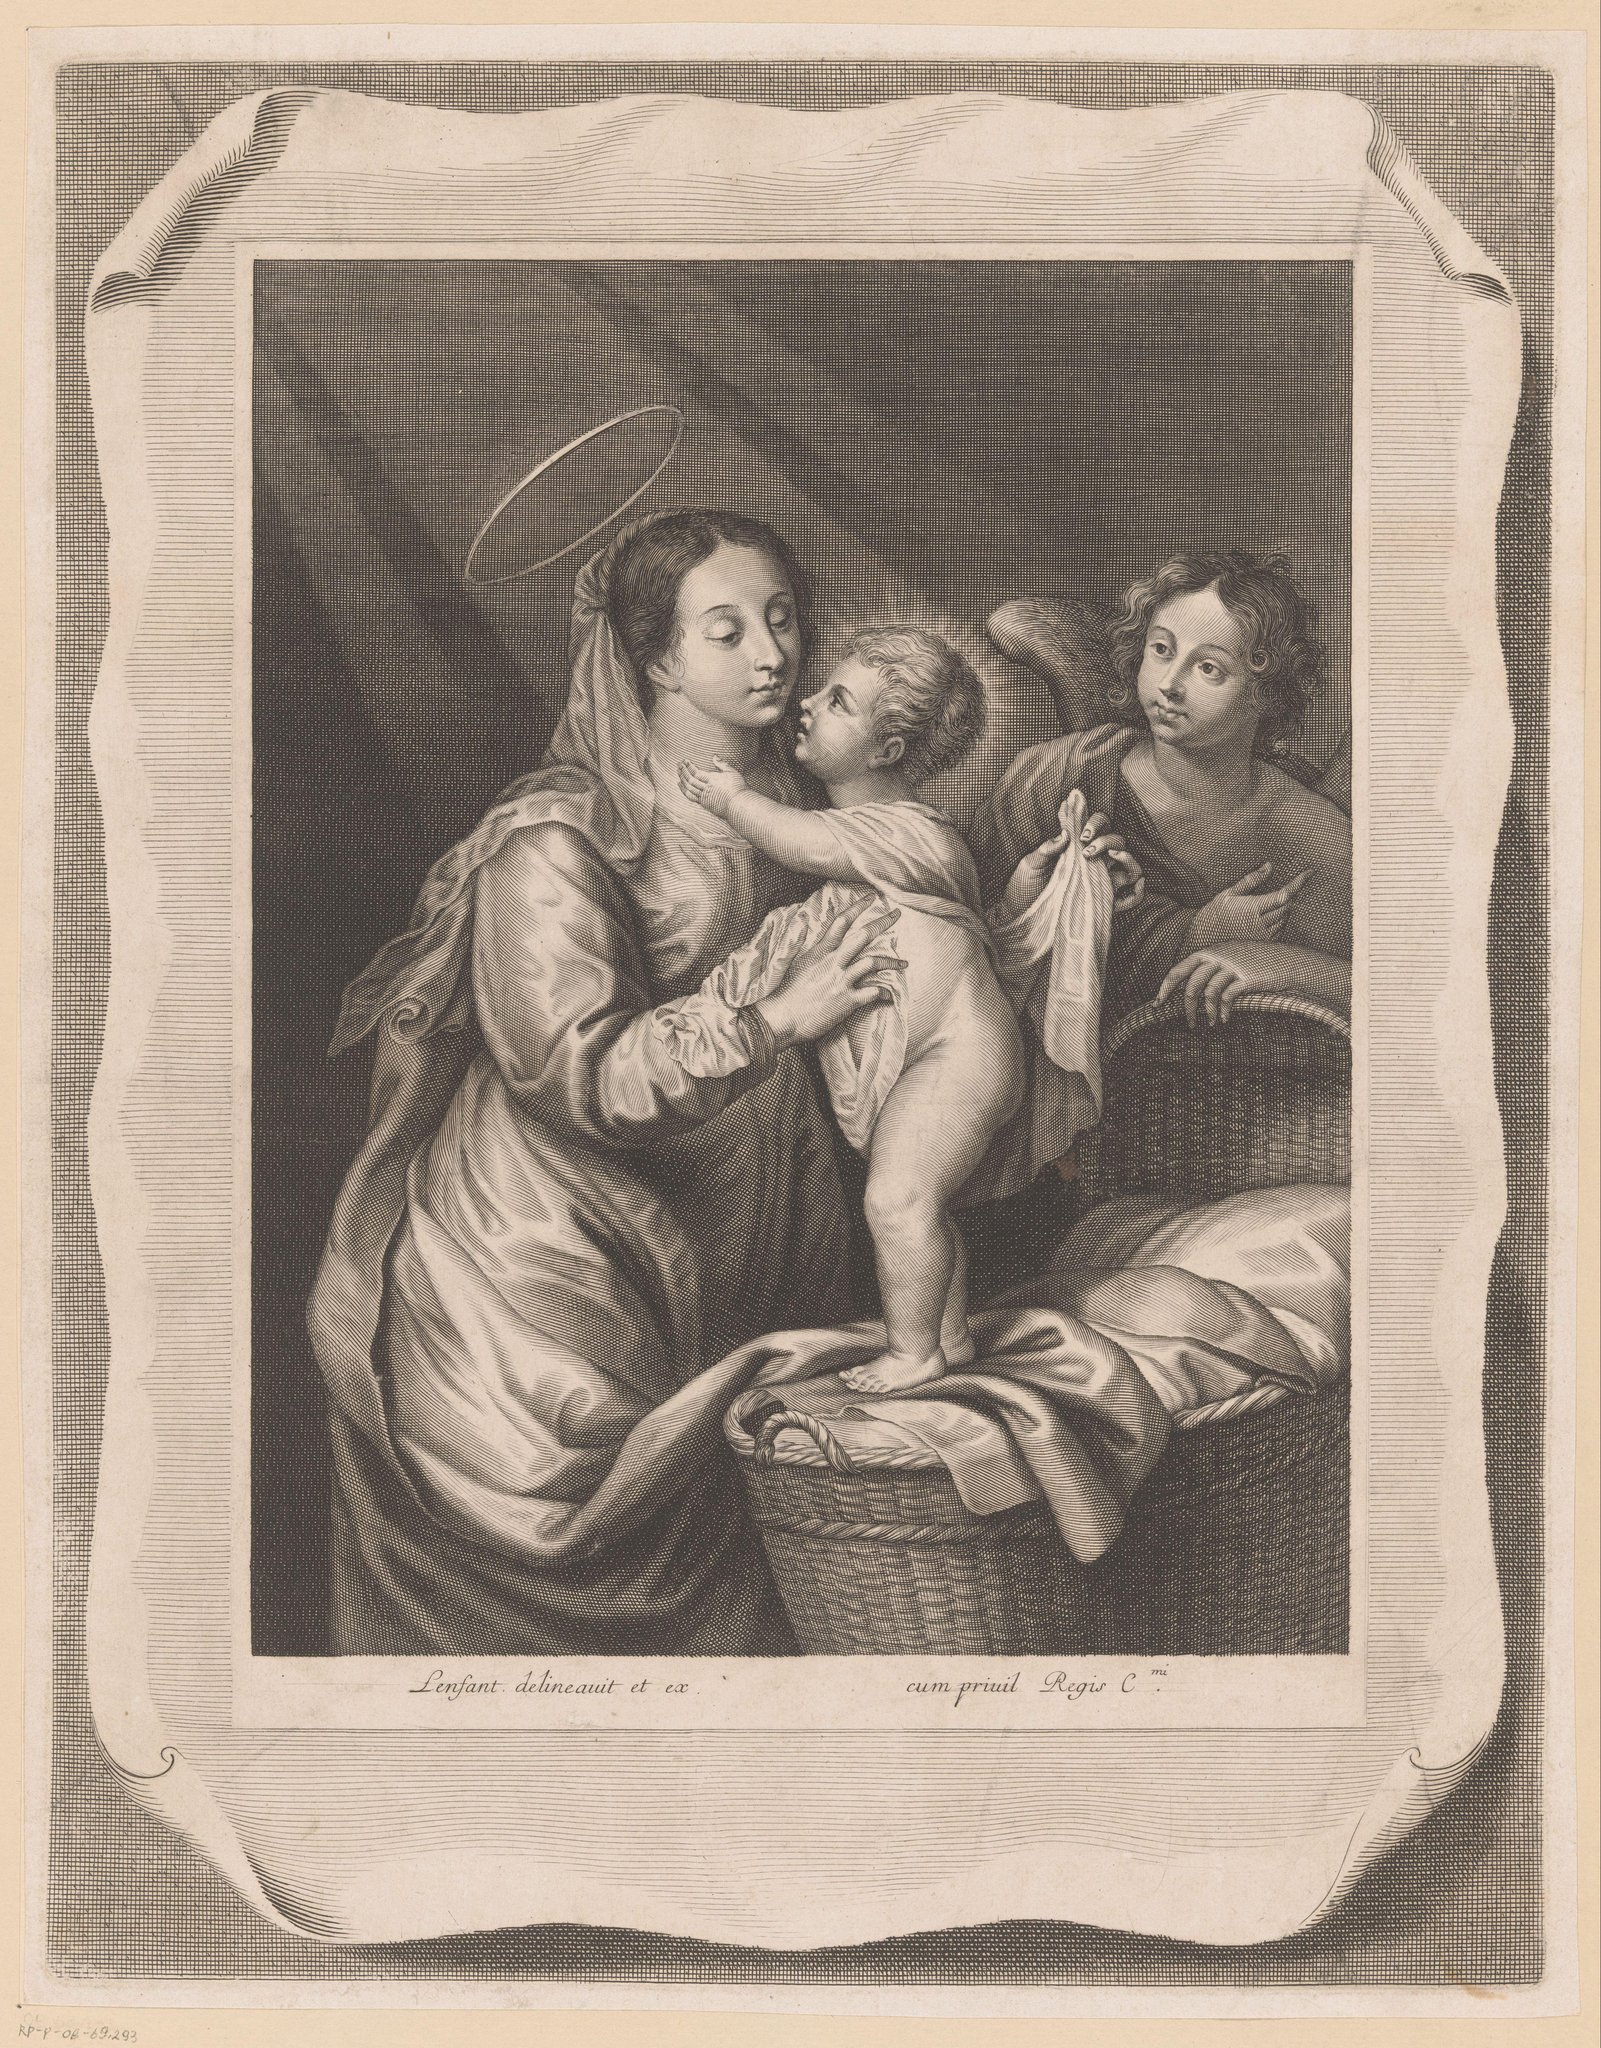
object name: print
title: Maria met Kind en engel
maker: lenfant (a paris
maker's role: print maker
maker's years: 1615-1674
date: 1625-1674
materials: paper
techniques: engraving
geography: france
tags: madonna: i.e. mary with the christ-child (+ angel(s)), cradle, crib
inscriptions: collector's mark: Lugt 240